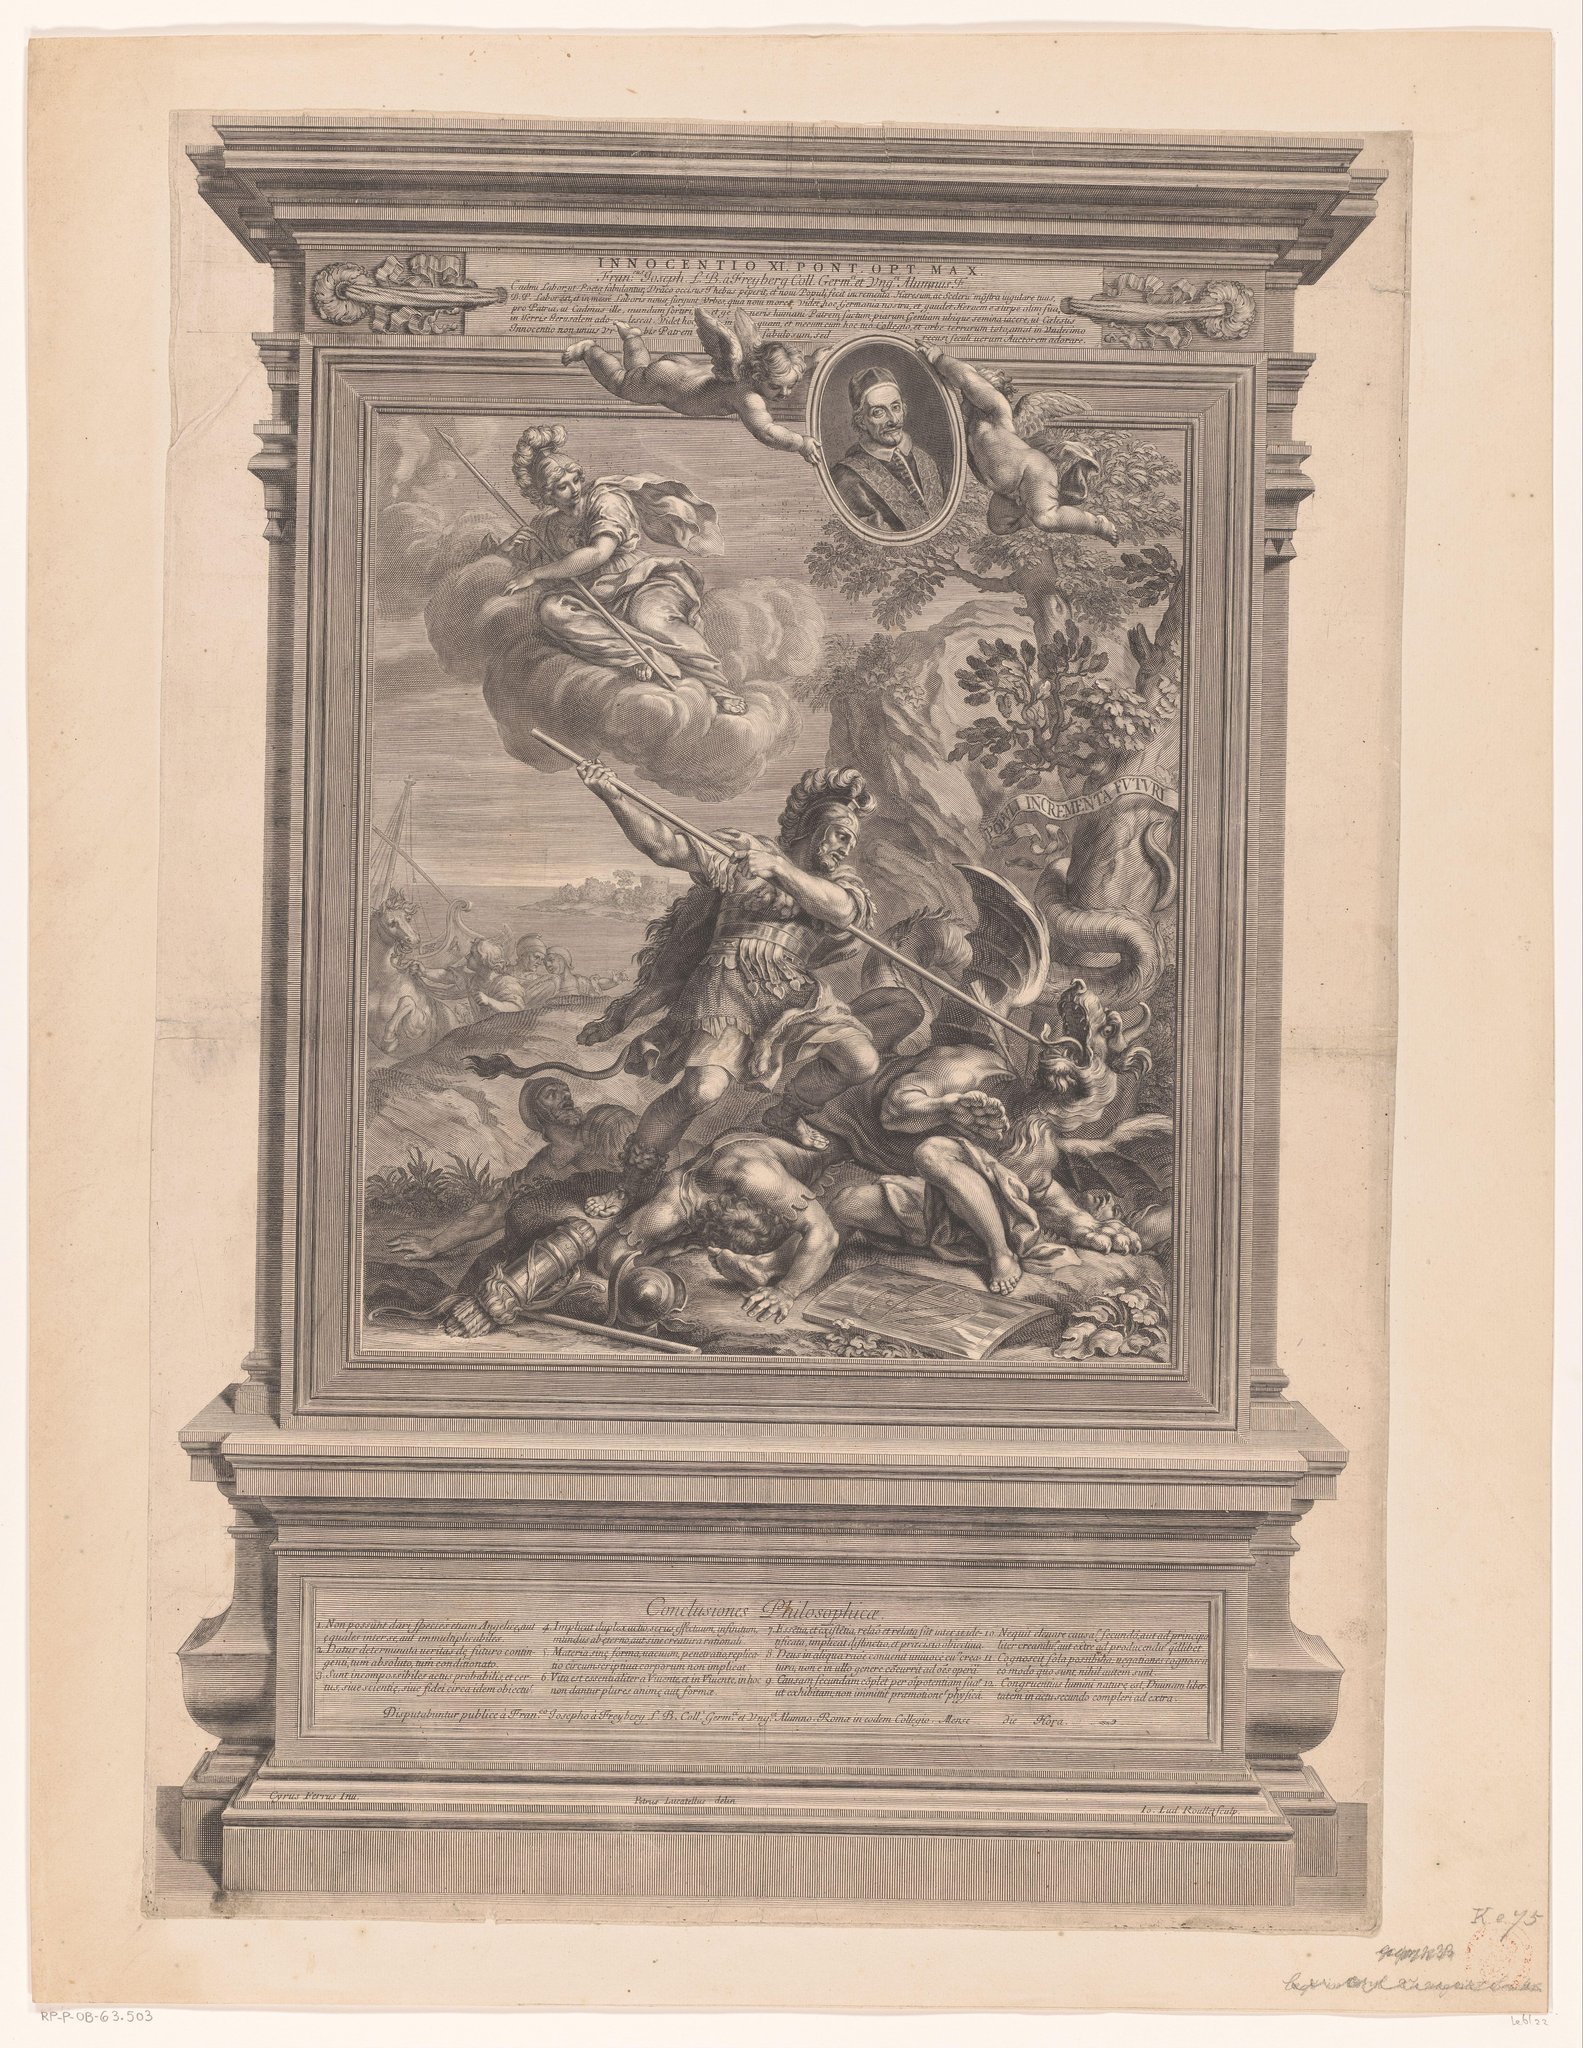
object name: print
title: Cadmus doodt de draak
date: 1655-1699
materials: paper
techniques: engraving, etching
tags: philosophy, cadmus slays the dragon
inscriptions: collector's mark: Lugt 240